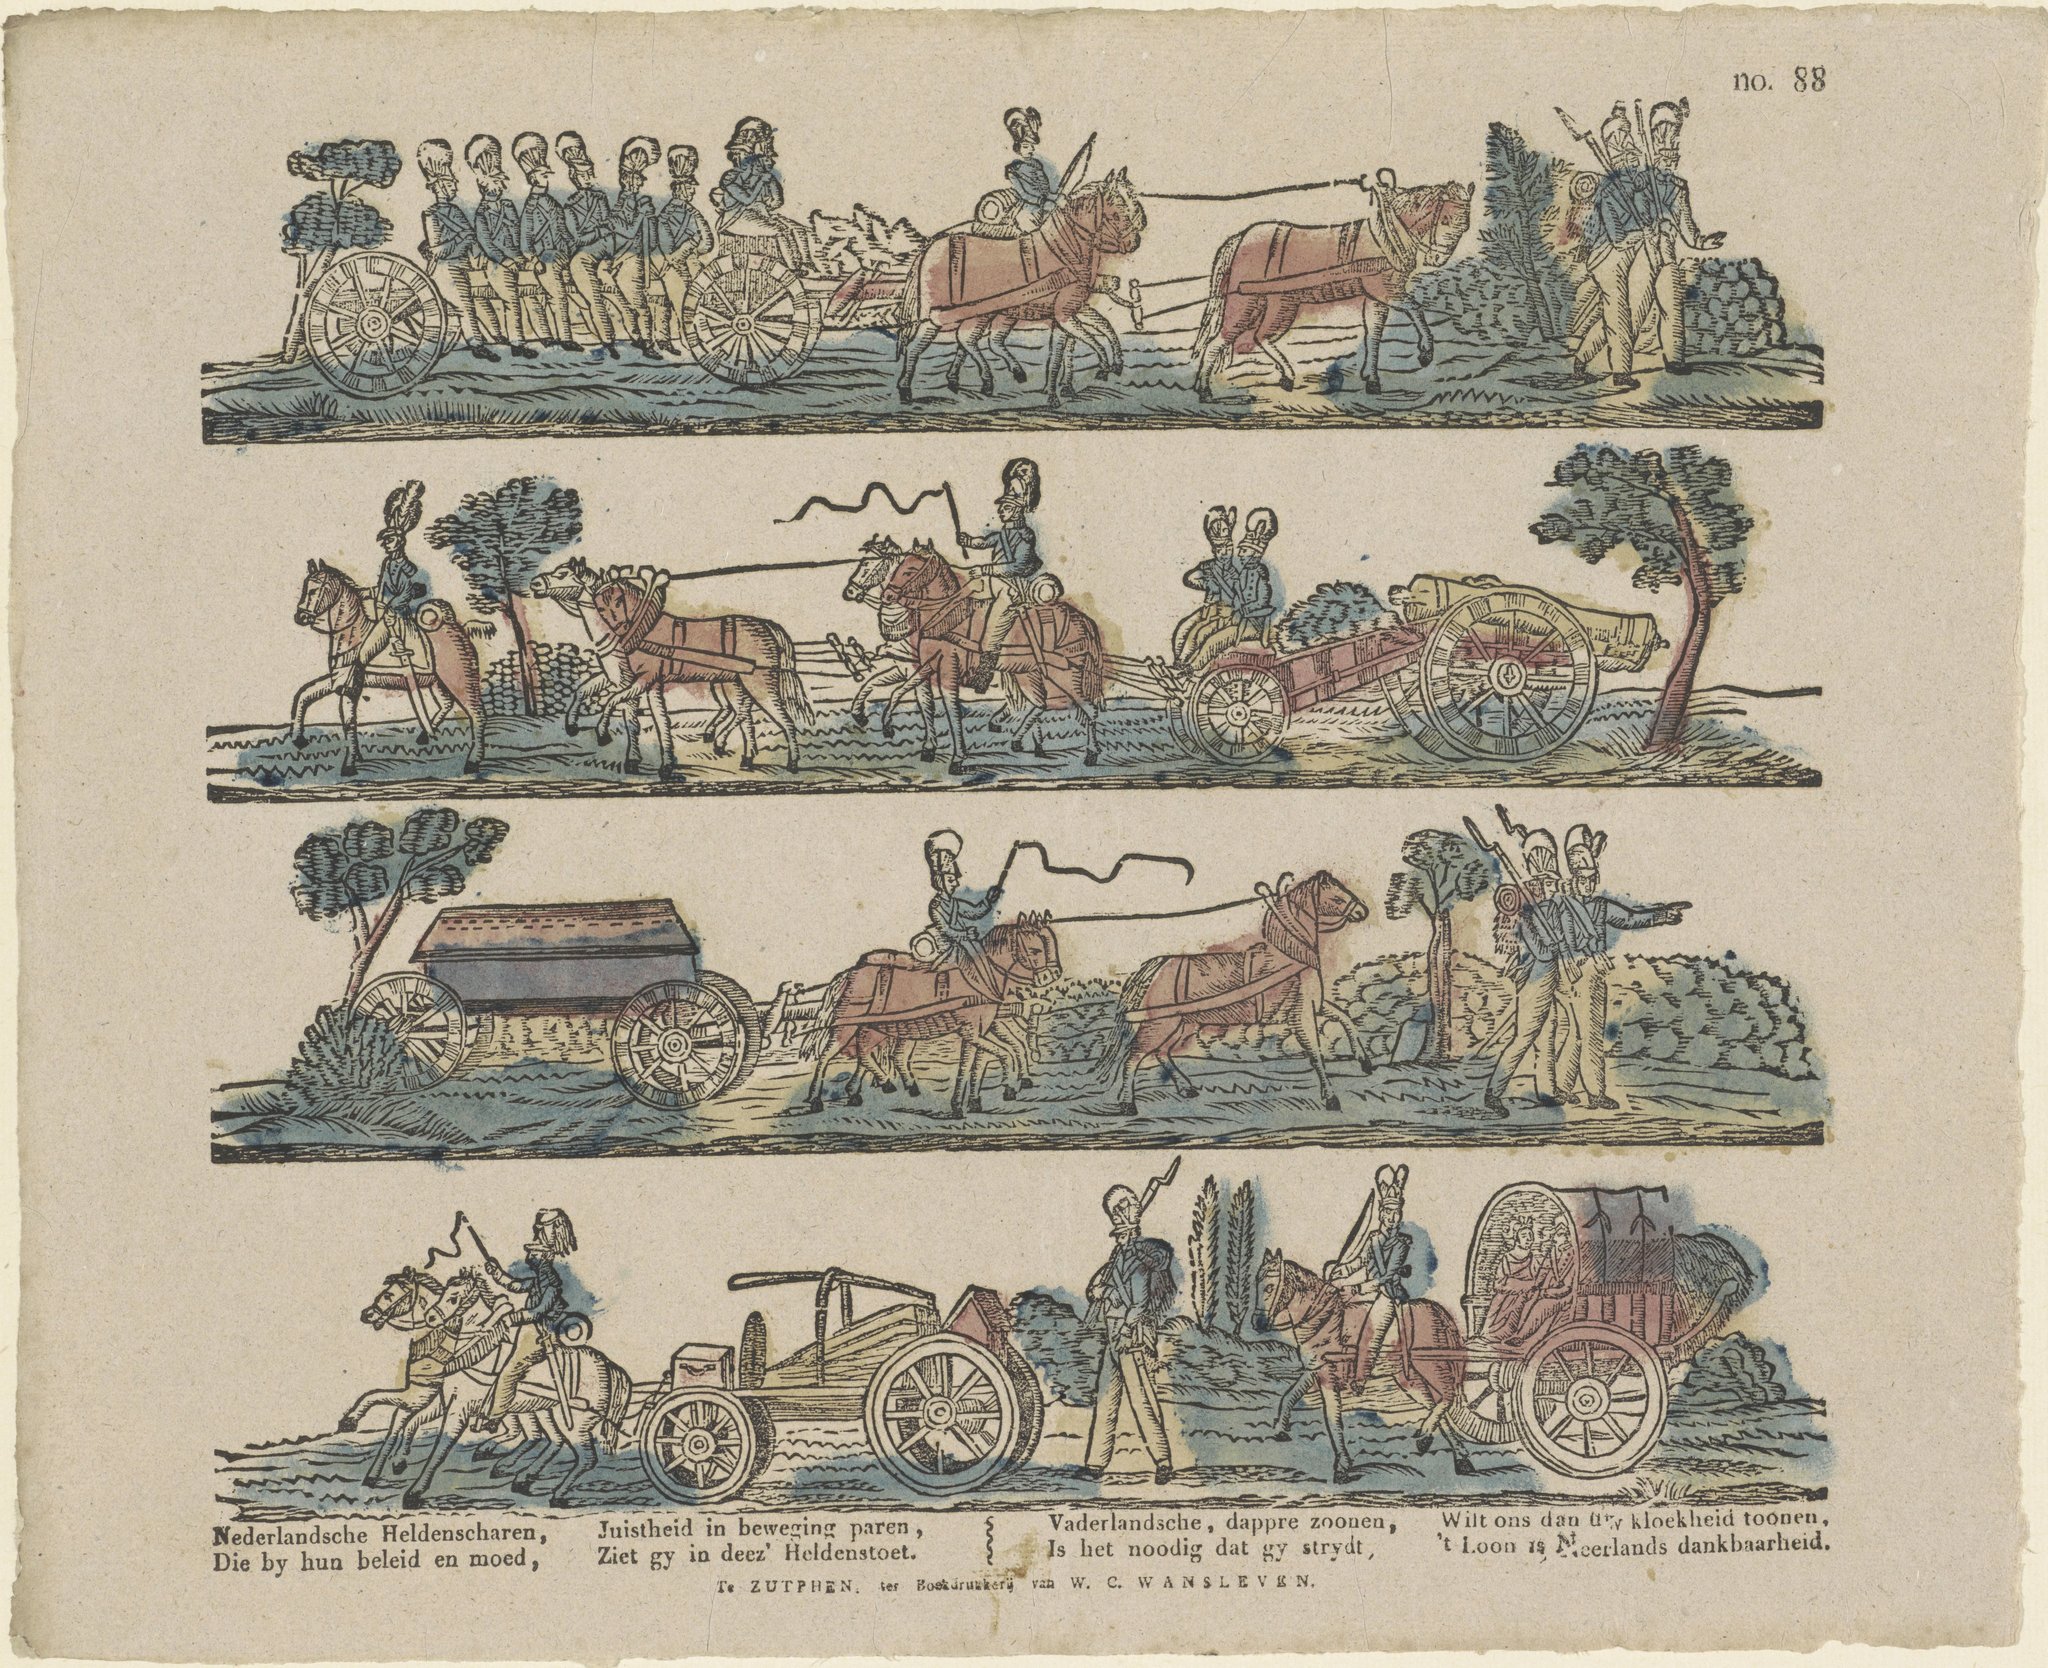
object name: popular print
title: Militaire wagens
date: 1806-1858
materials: paper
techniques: colour, letterpress printing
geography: netherlands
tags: the soldier; the soldier's life, (military) equipment and supply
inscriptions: collector's mark: Lugt 2760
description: Blad met 4 horizontale rijen met voorstellingen met militairen en wagens voortgetrokken door paarden. In der ondermarge een achtregelig vers in vier kolommen. Genummerd rechtsboven: no. 88.